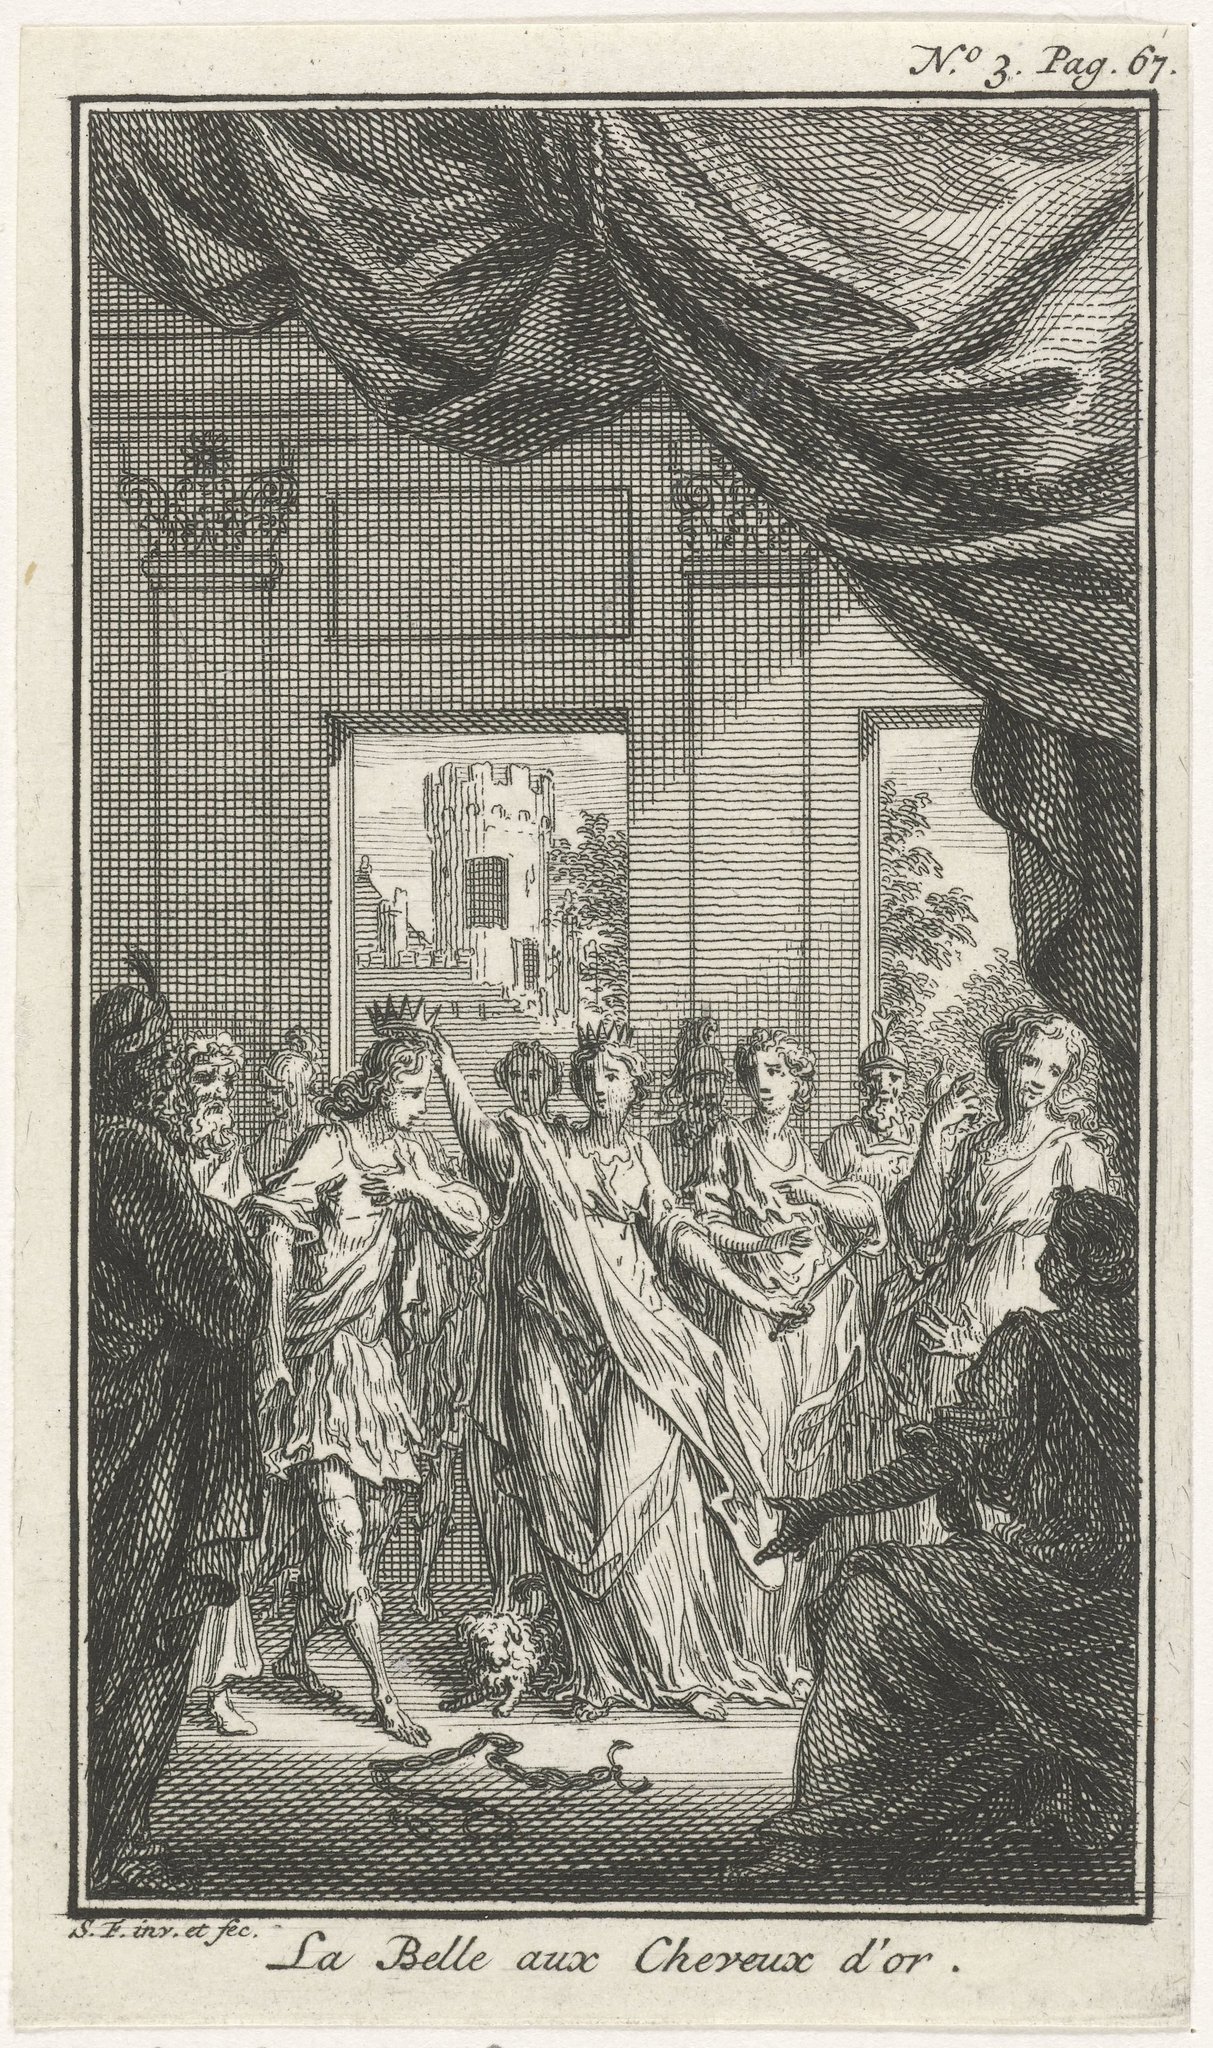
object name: print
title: Man in gezelschap gekroond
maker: simon fokke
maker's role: draughtsman, print maker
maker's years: 1712-1784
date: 1722-1784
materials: paper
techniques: etching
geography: amsterdam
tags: coronation of a ruler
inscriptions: collector's mark: Lugt 240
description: Een man wordt in een gezelschap gekroond door een kroondragende vrouw met scepter in haar hand. Op de voorgrond liggen opengebroken handboeien aan een ketting. Prent rechtsboven gemerkt: No. 3. Pag. 67.